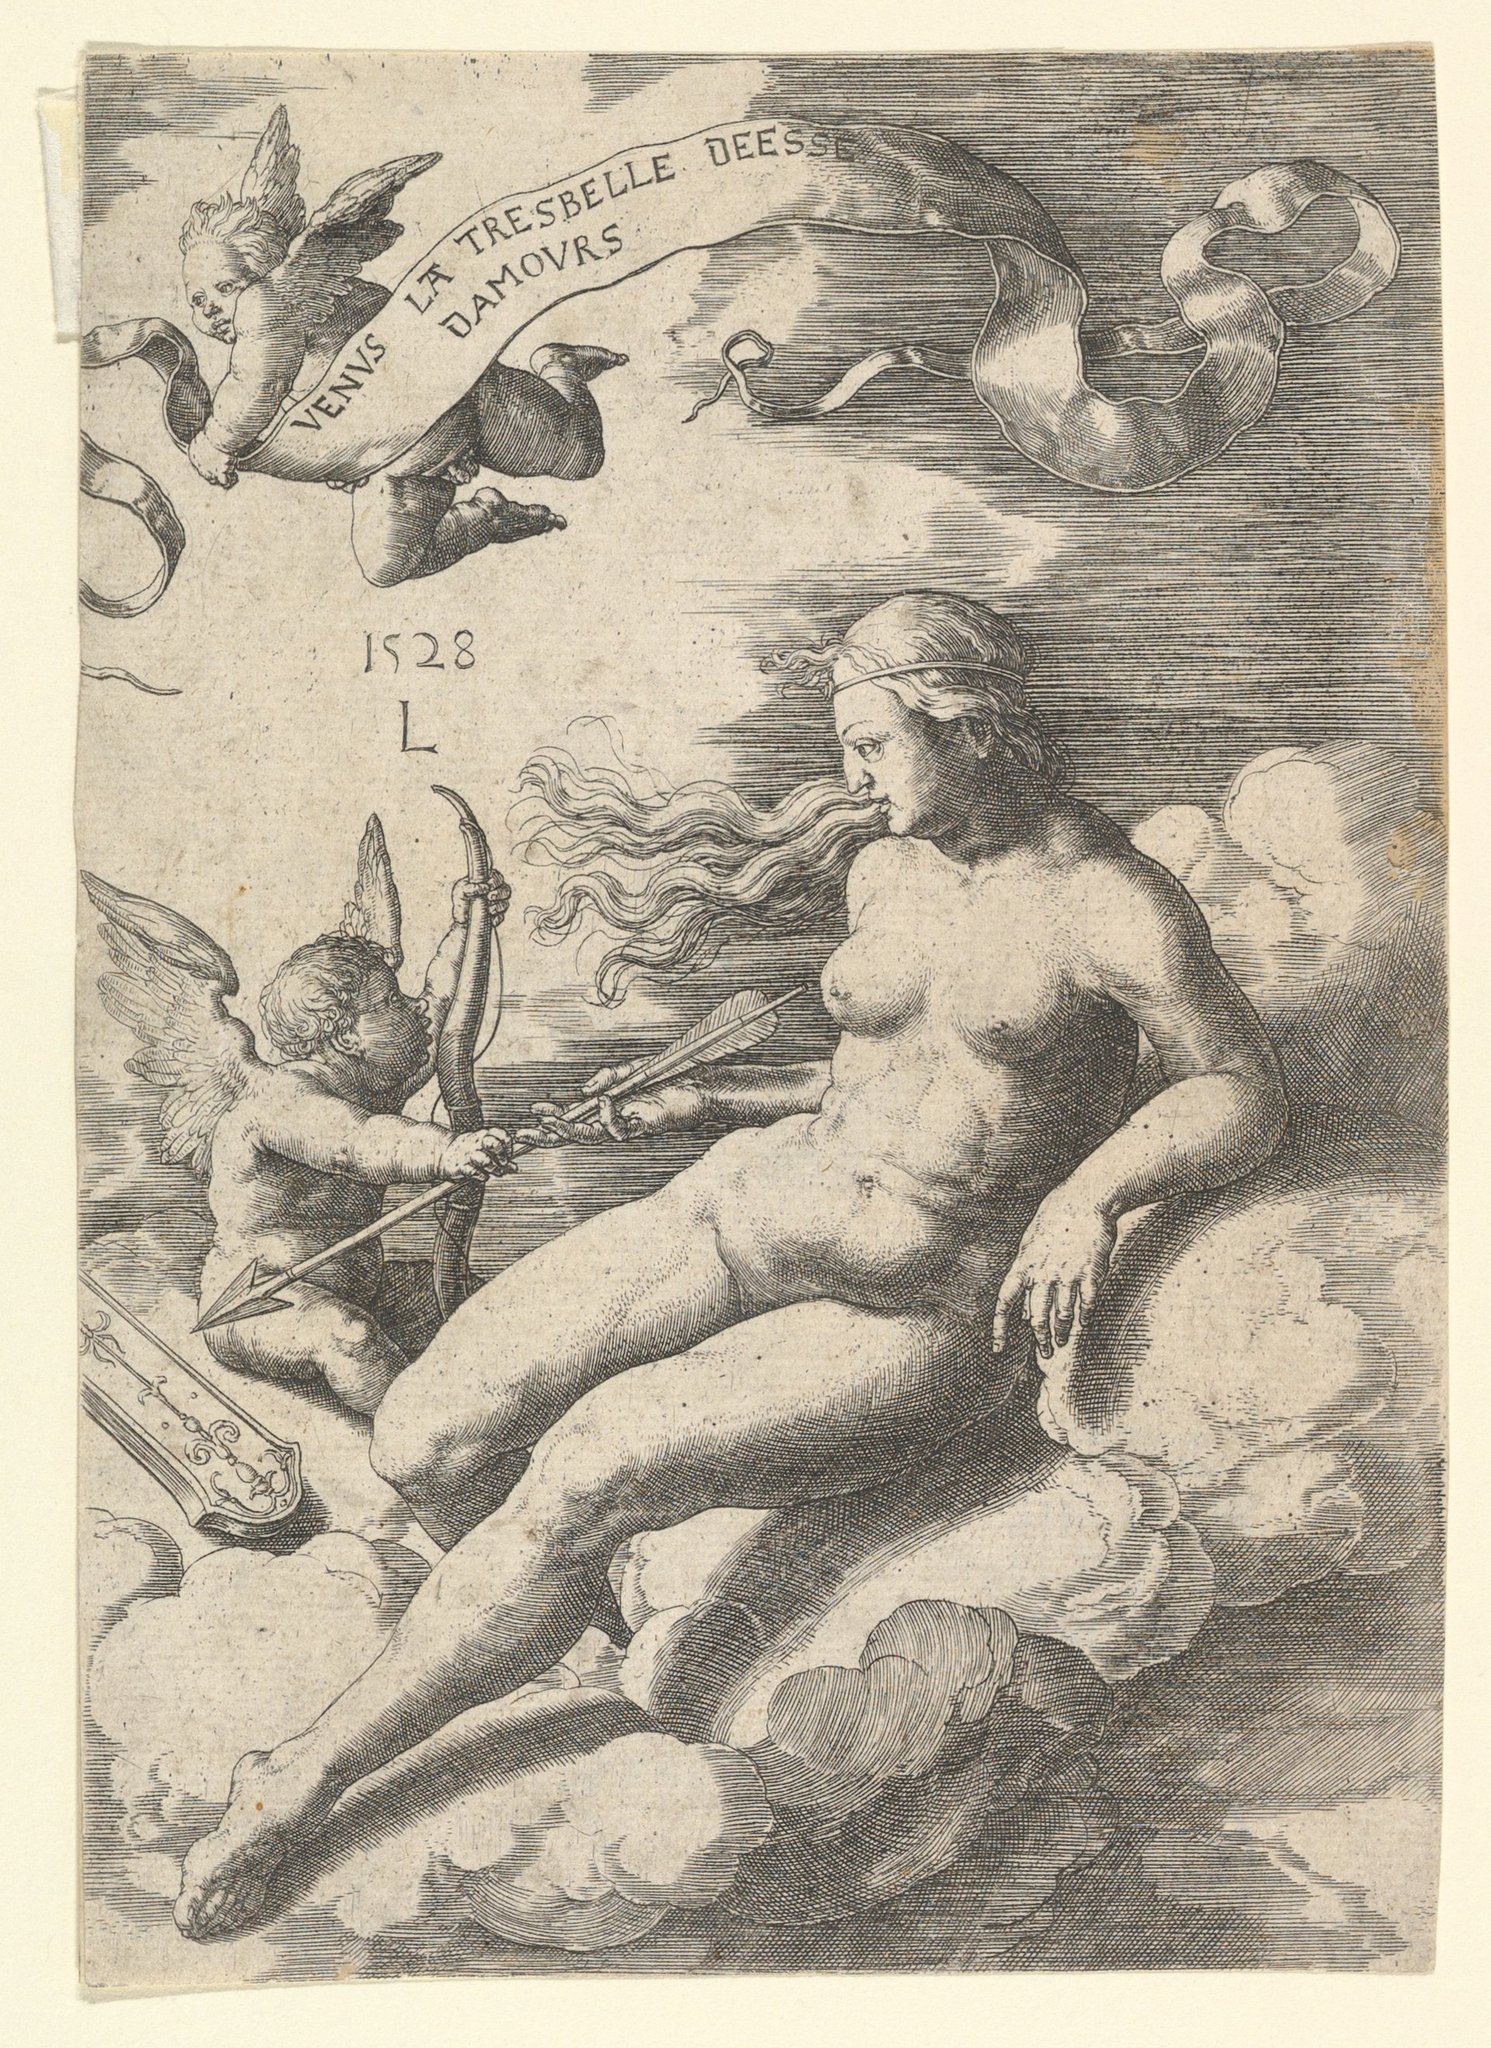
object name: print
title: Venus and Cupid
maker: lucas van leyden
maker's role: artist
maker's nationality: netherlandish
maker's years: 1494-1533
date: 1528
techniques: engraving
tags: bow and arrow,female nudes,cupid,venus